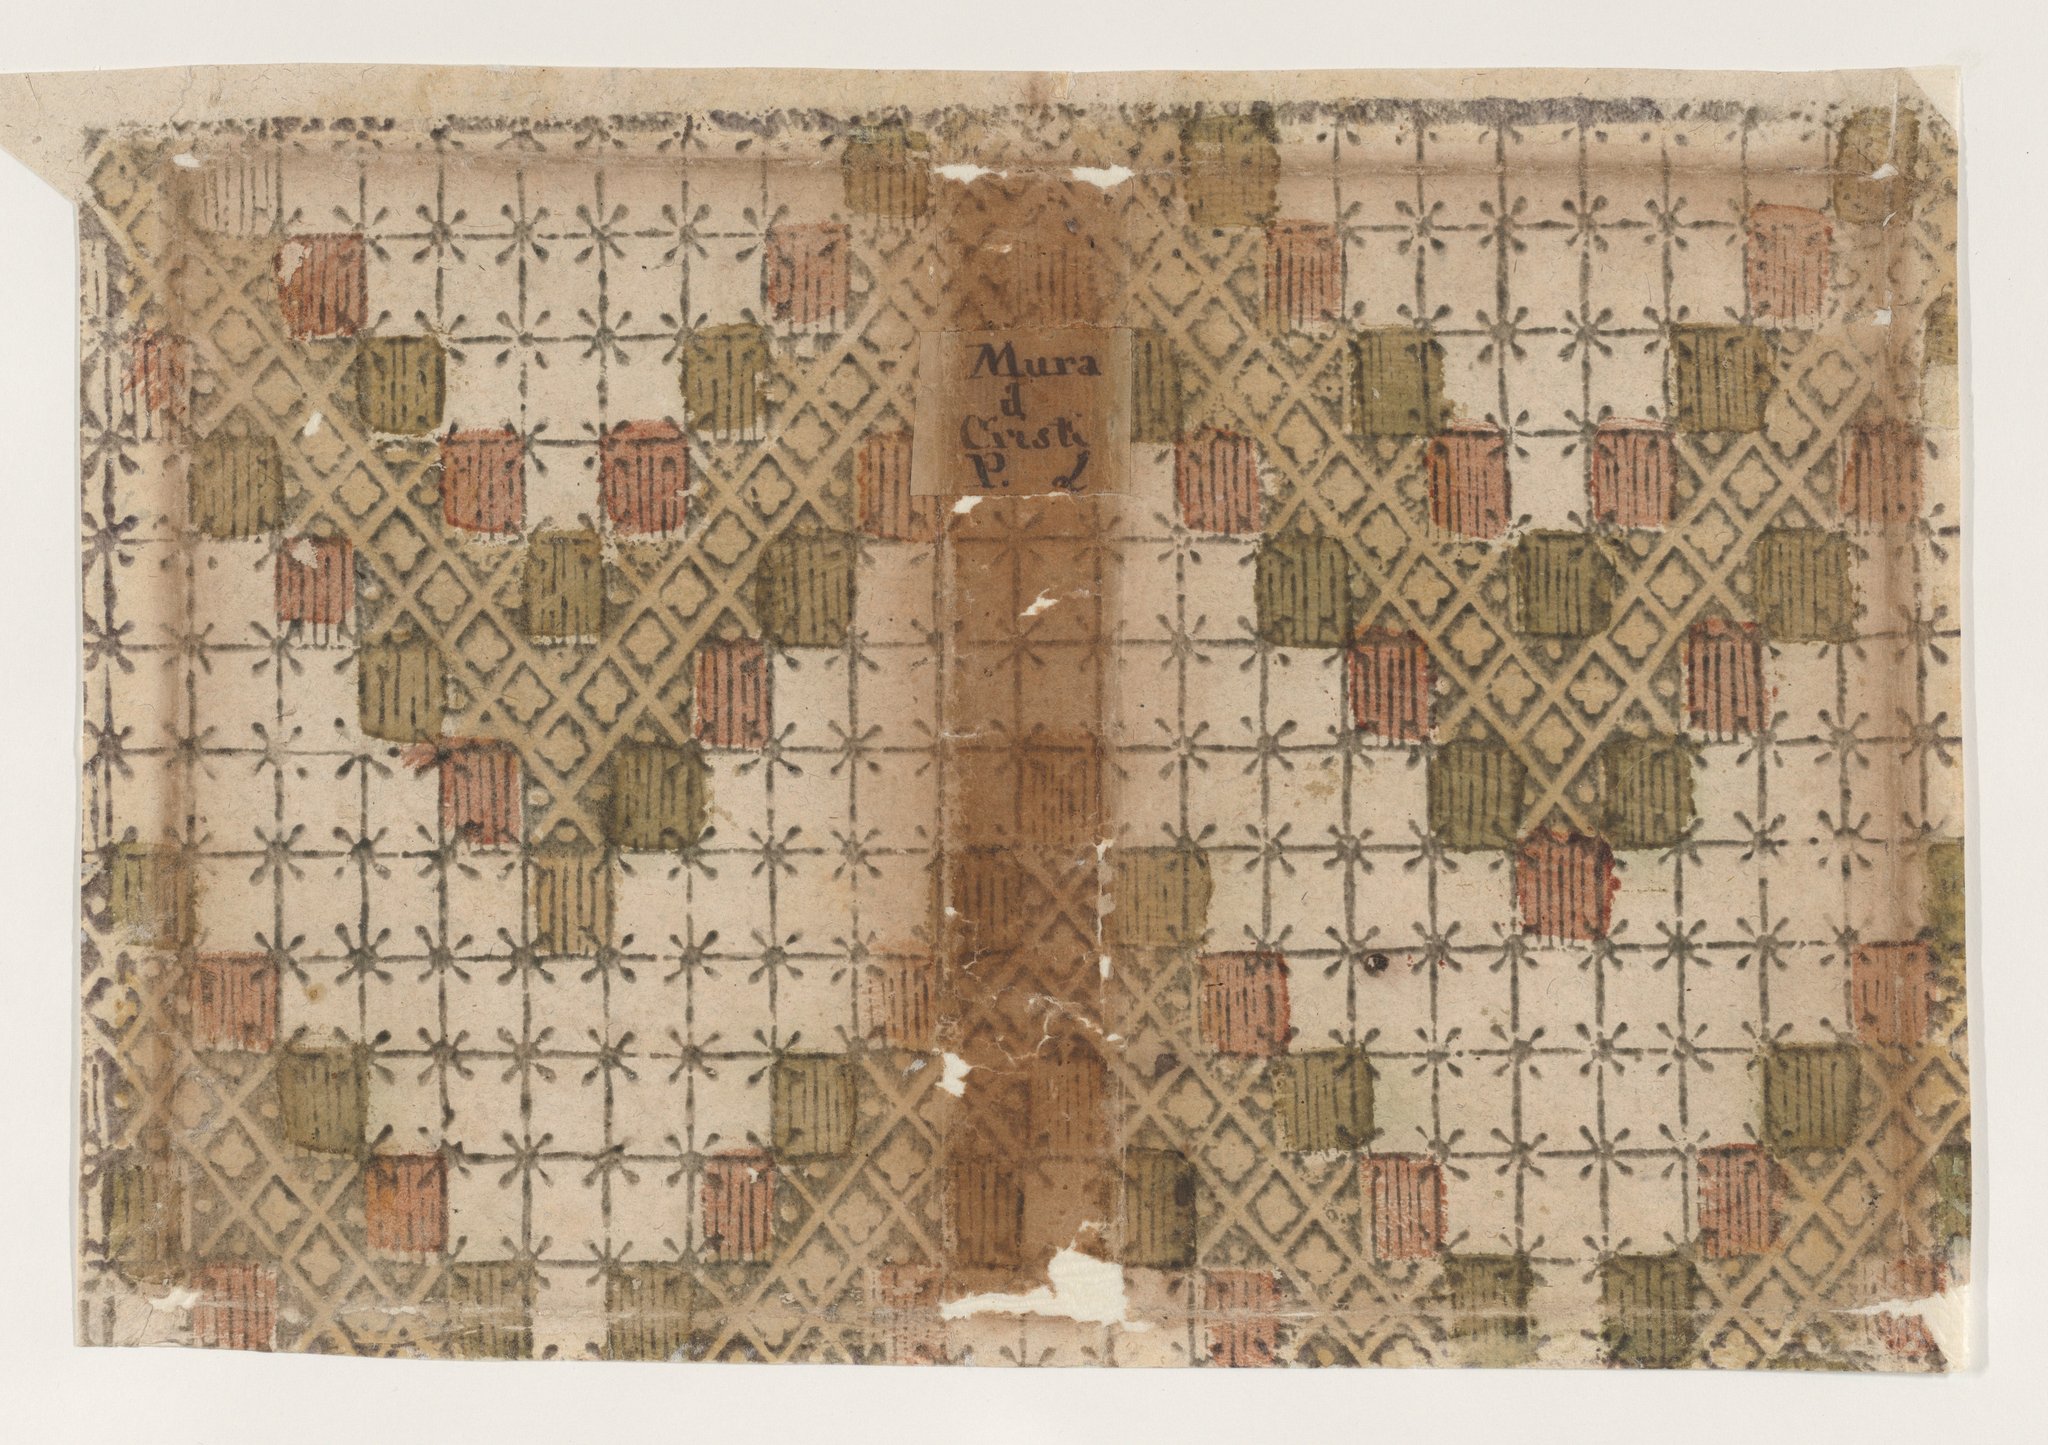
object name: print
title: Book cover with overall geometric pattern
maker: Anonymous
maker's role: artist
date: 1801-1900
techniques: relief print